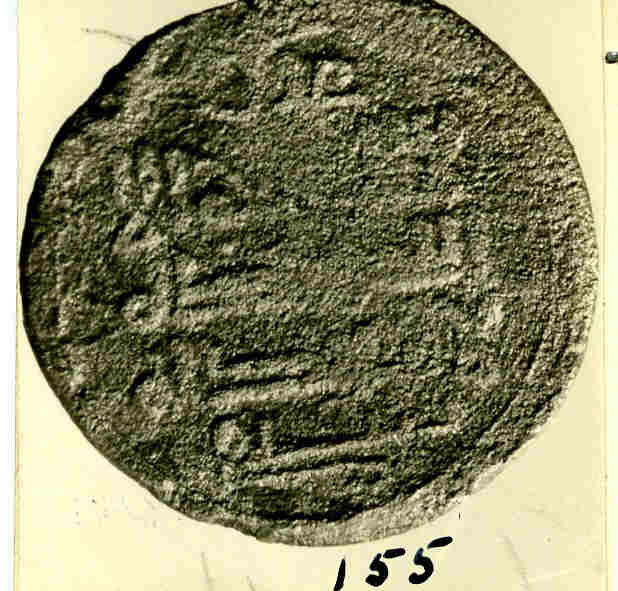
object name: coin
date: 1001-1100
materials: copper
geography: iran